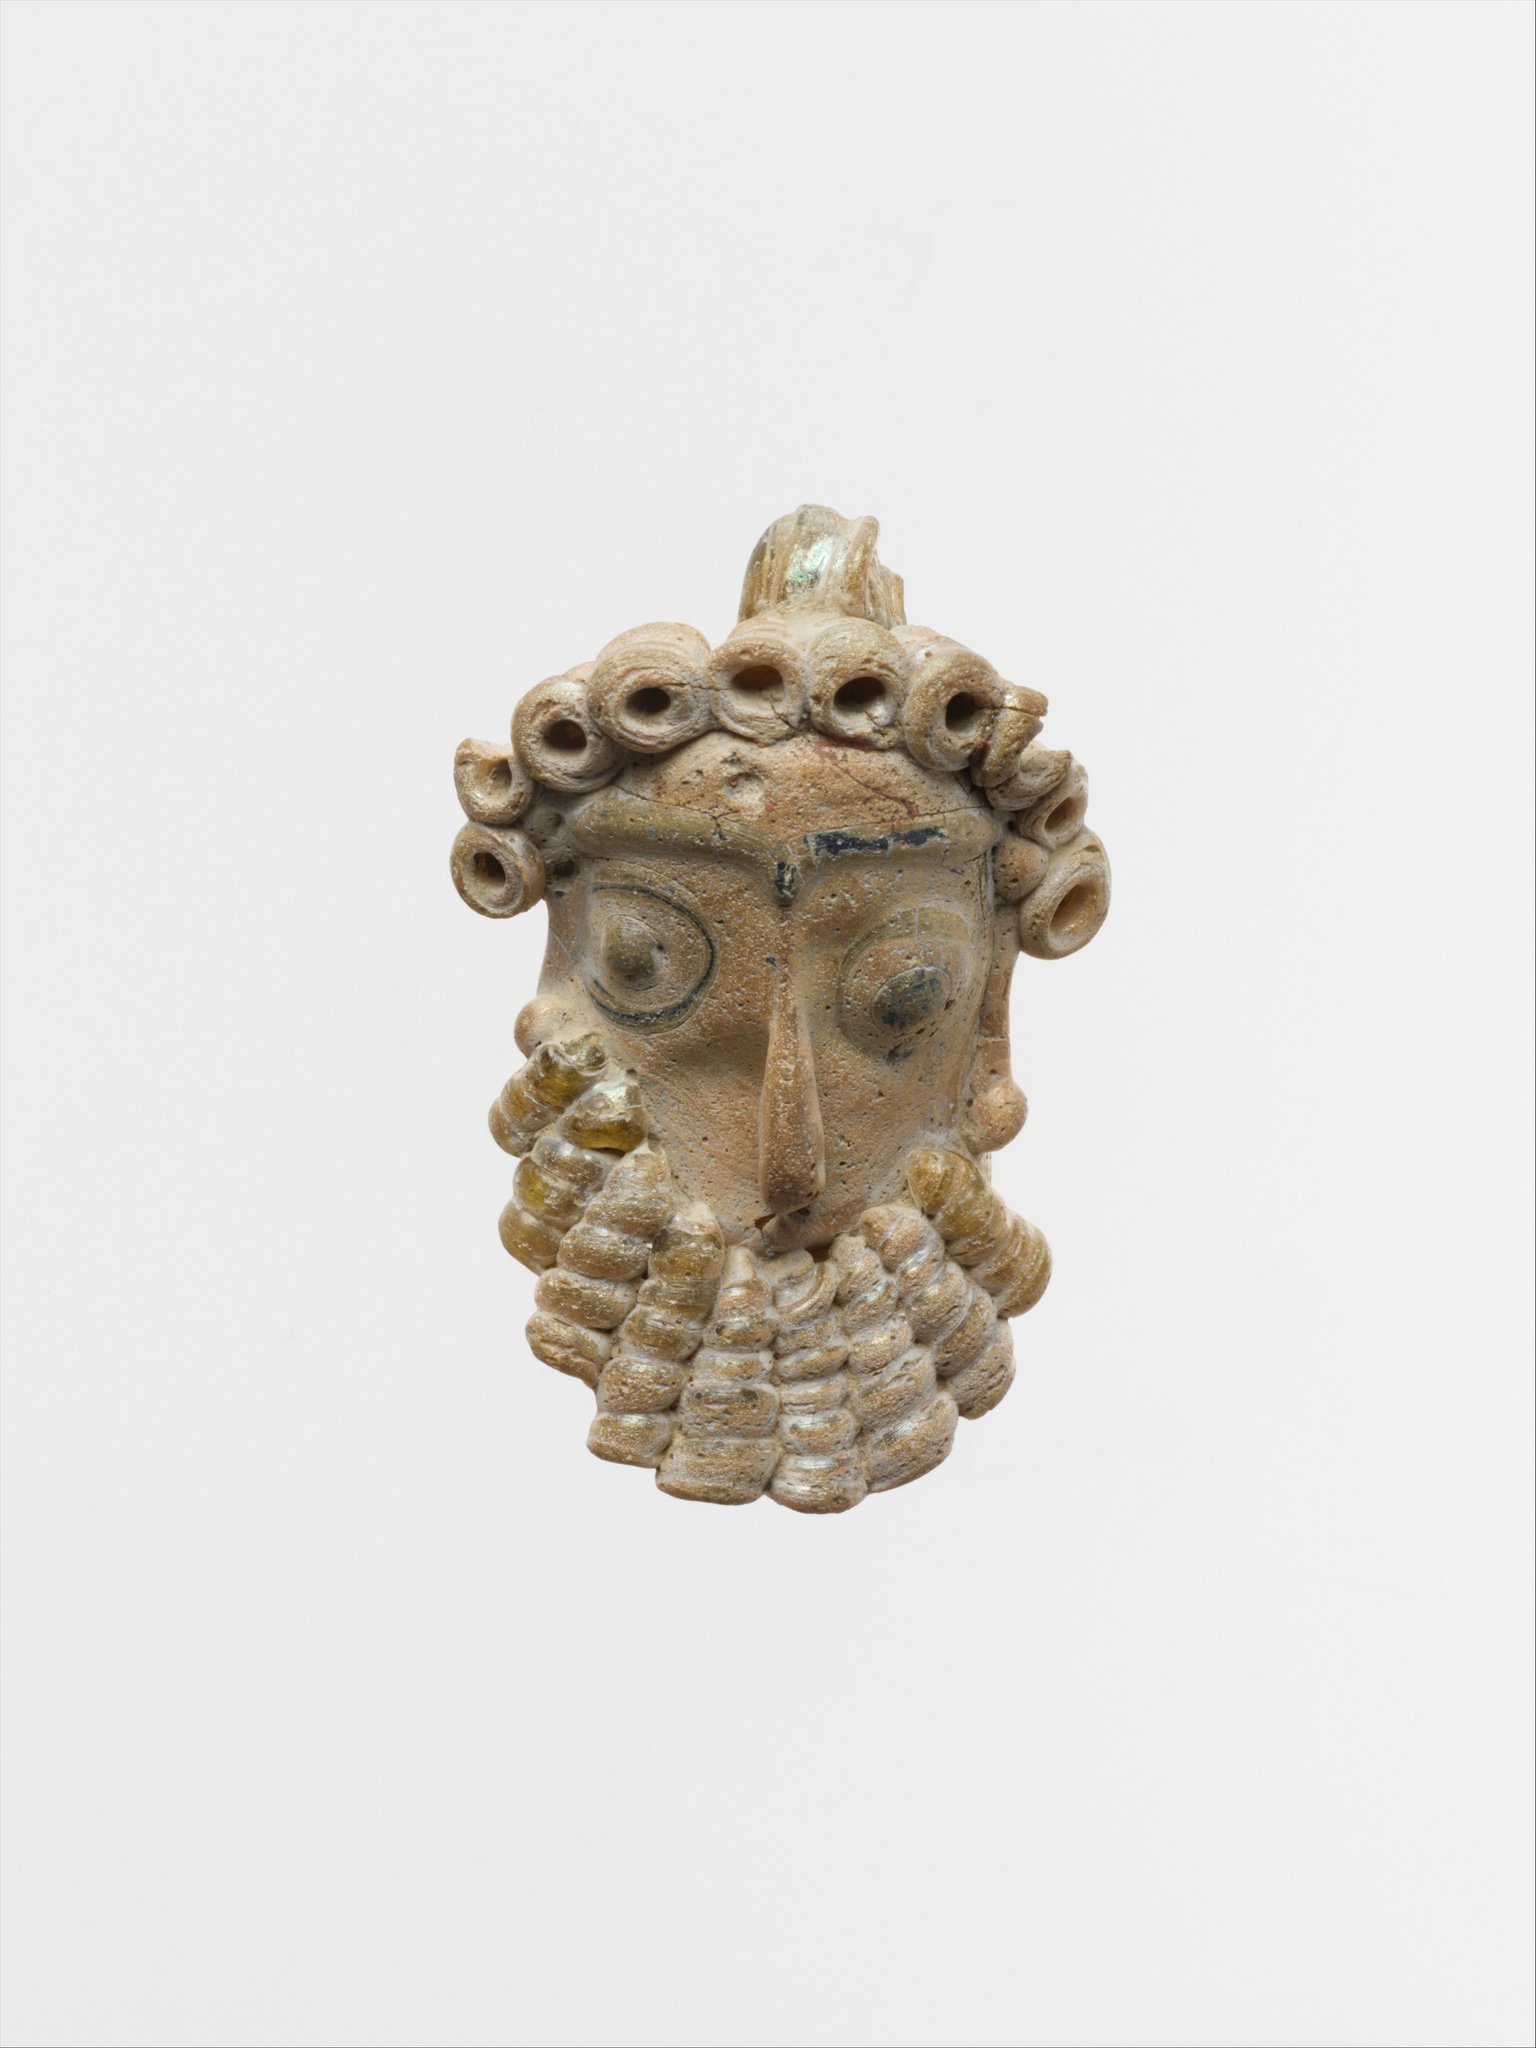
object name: pendant in the form of a man's head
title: Glass head pendant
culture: carthaginian or phoenician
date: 450-300 BCE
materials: glass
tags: heads